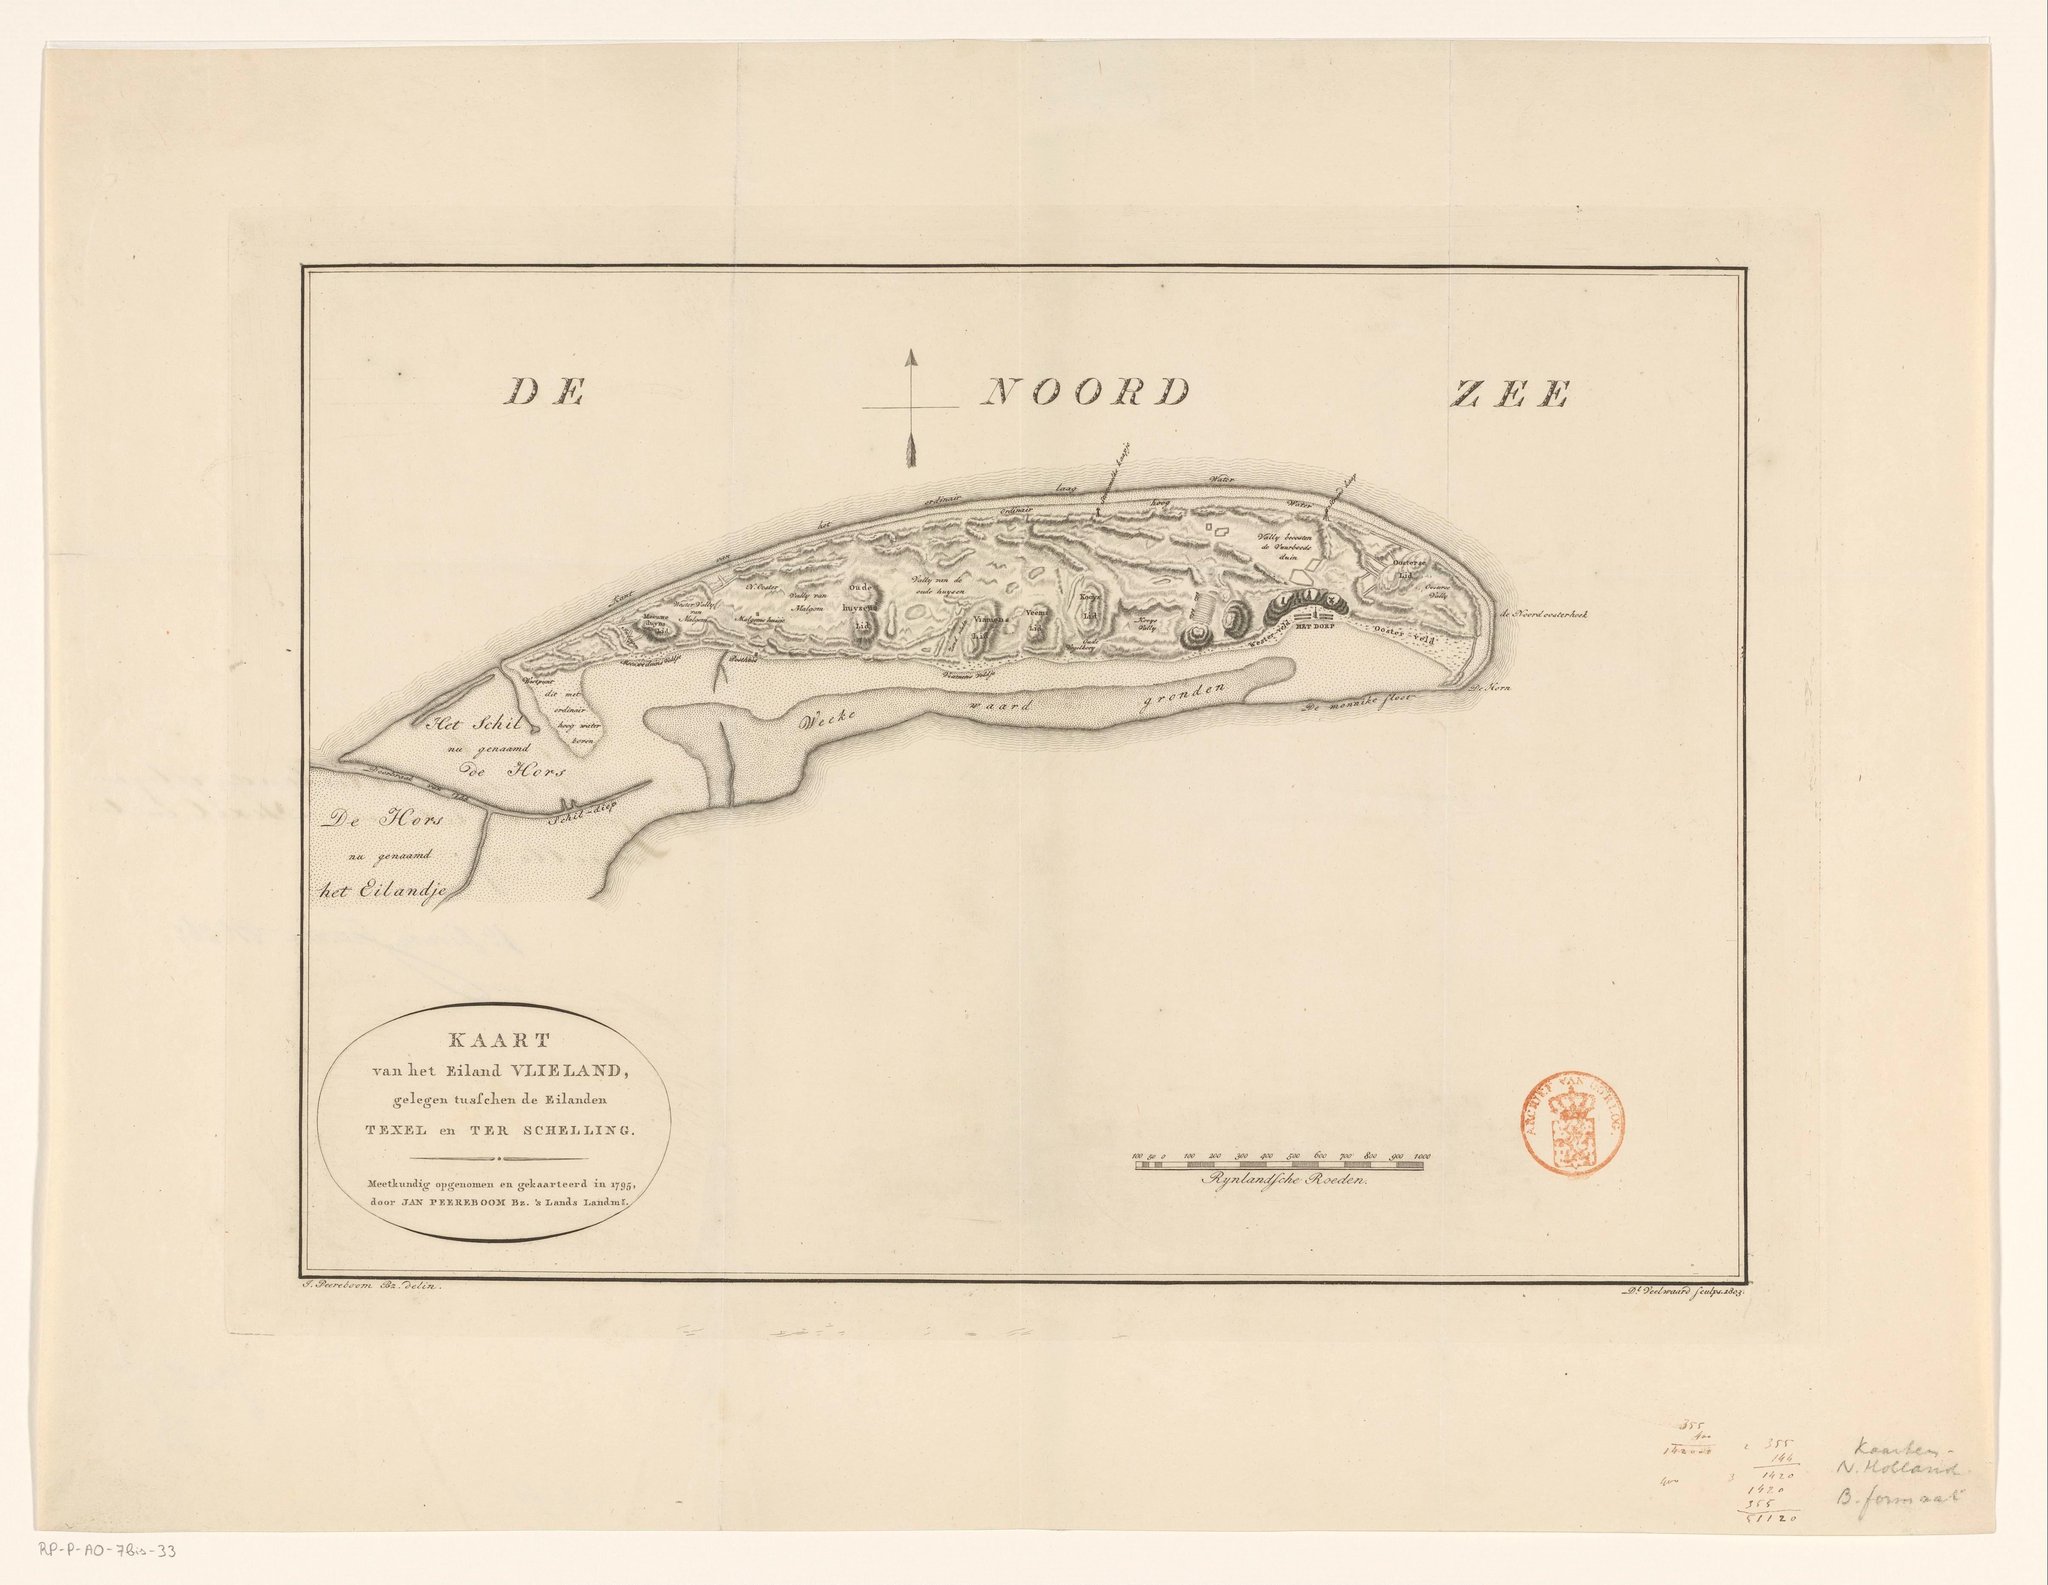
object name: print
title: Kaart van het eiland Vlieland, gelegen tusschen de eilanden Texel en Terschelling …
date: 1803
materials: paper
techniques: engraving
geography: amsterdam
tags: maps of separate countries or regions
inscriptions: collector's mark: Lugt 19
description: Linksonder de titelcartouche, rechtsonder een schaalstok: Rynlandsche roeden.